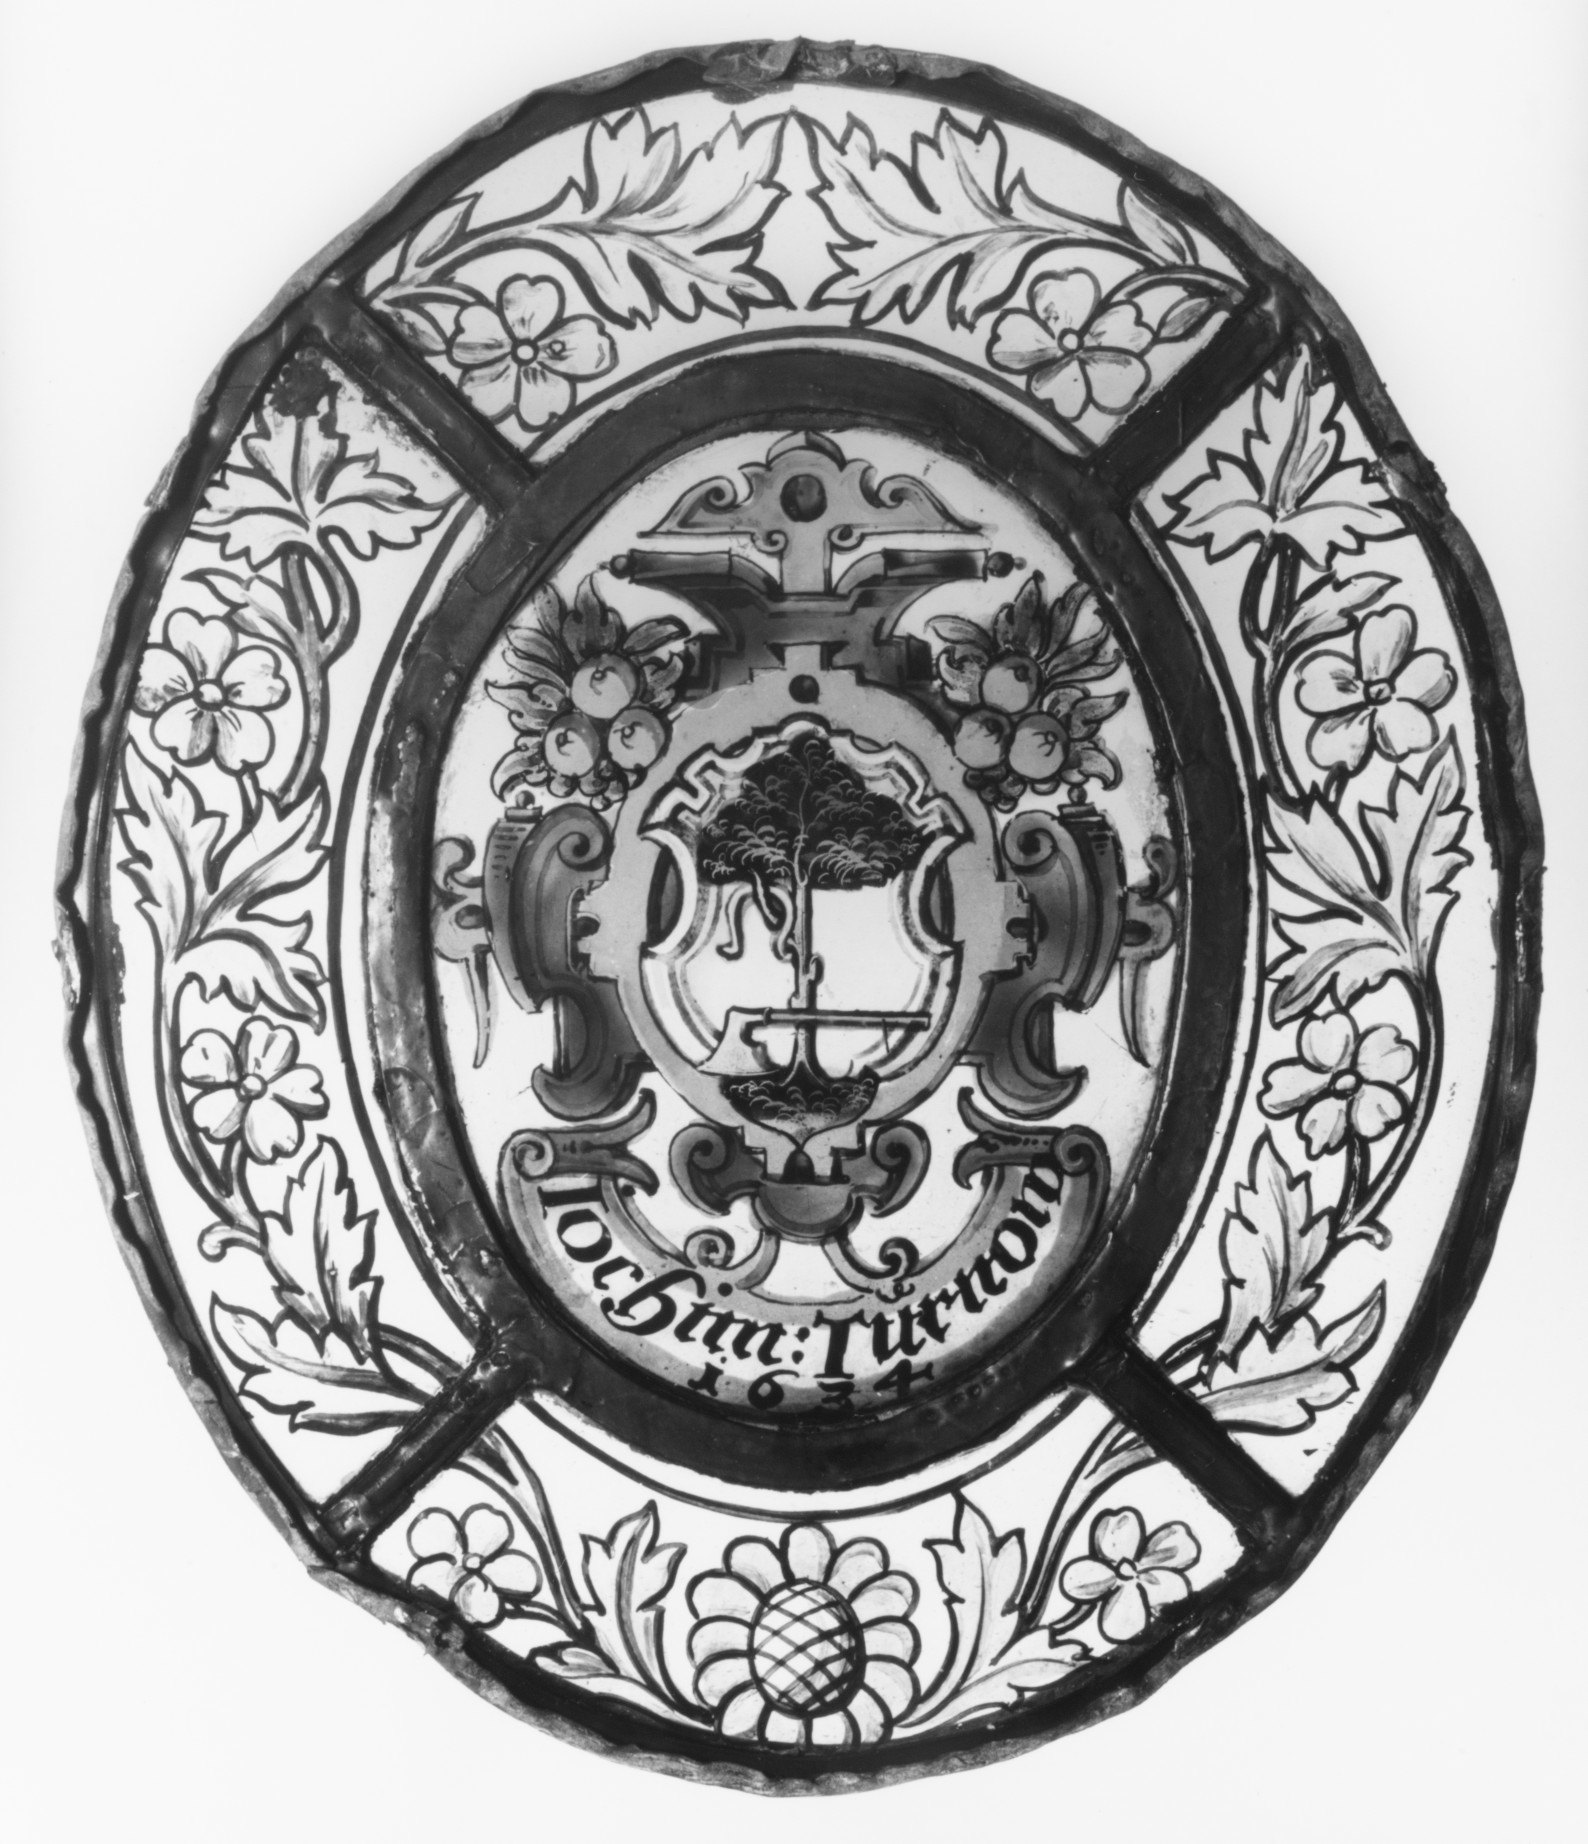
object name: armorial panel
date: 1634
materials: glass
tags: flowers,leaves,coat of arms